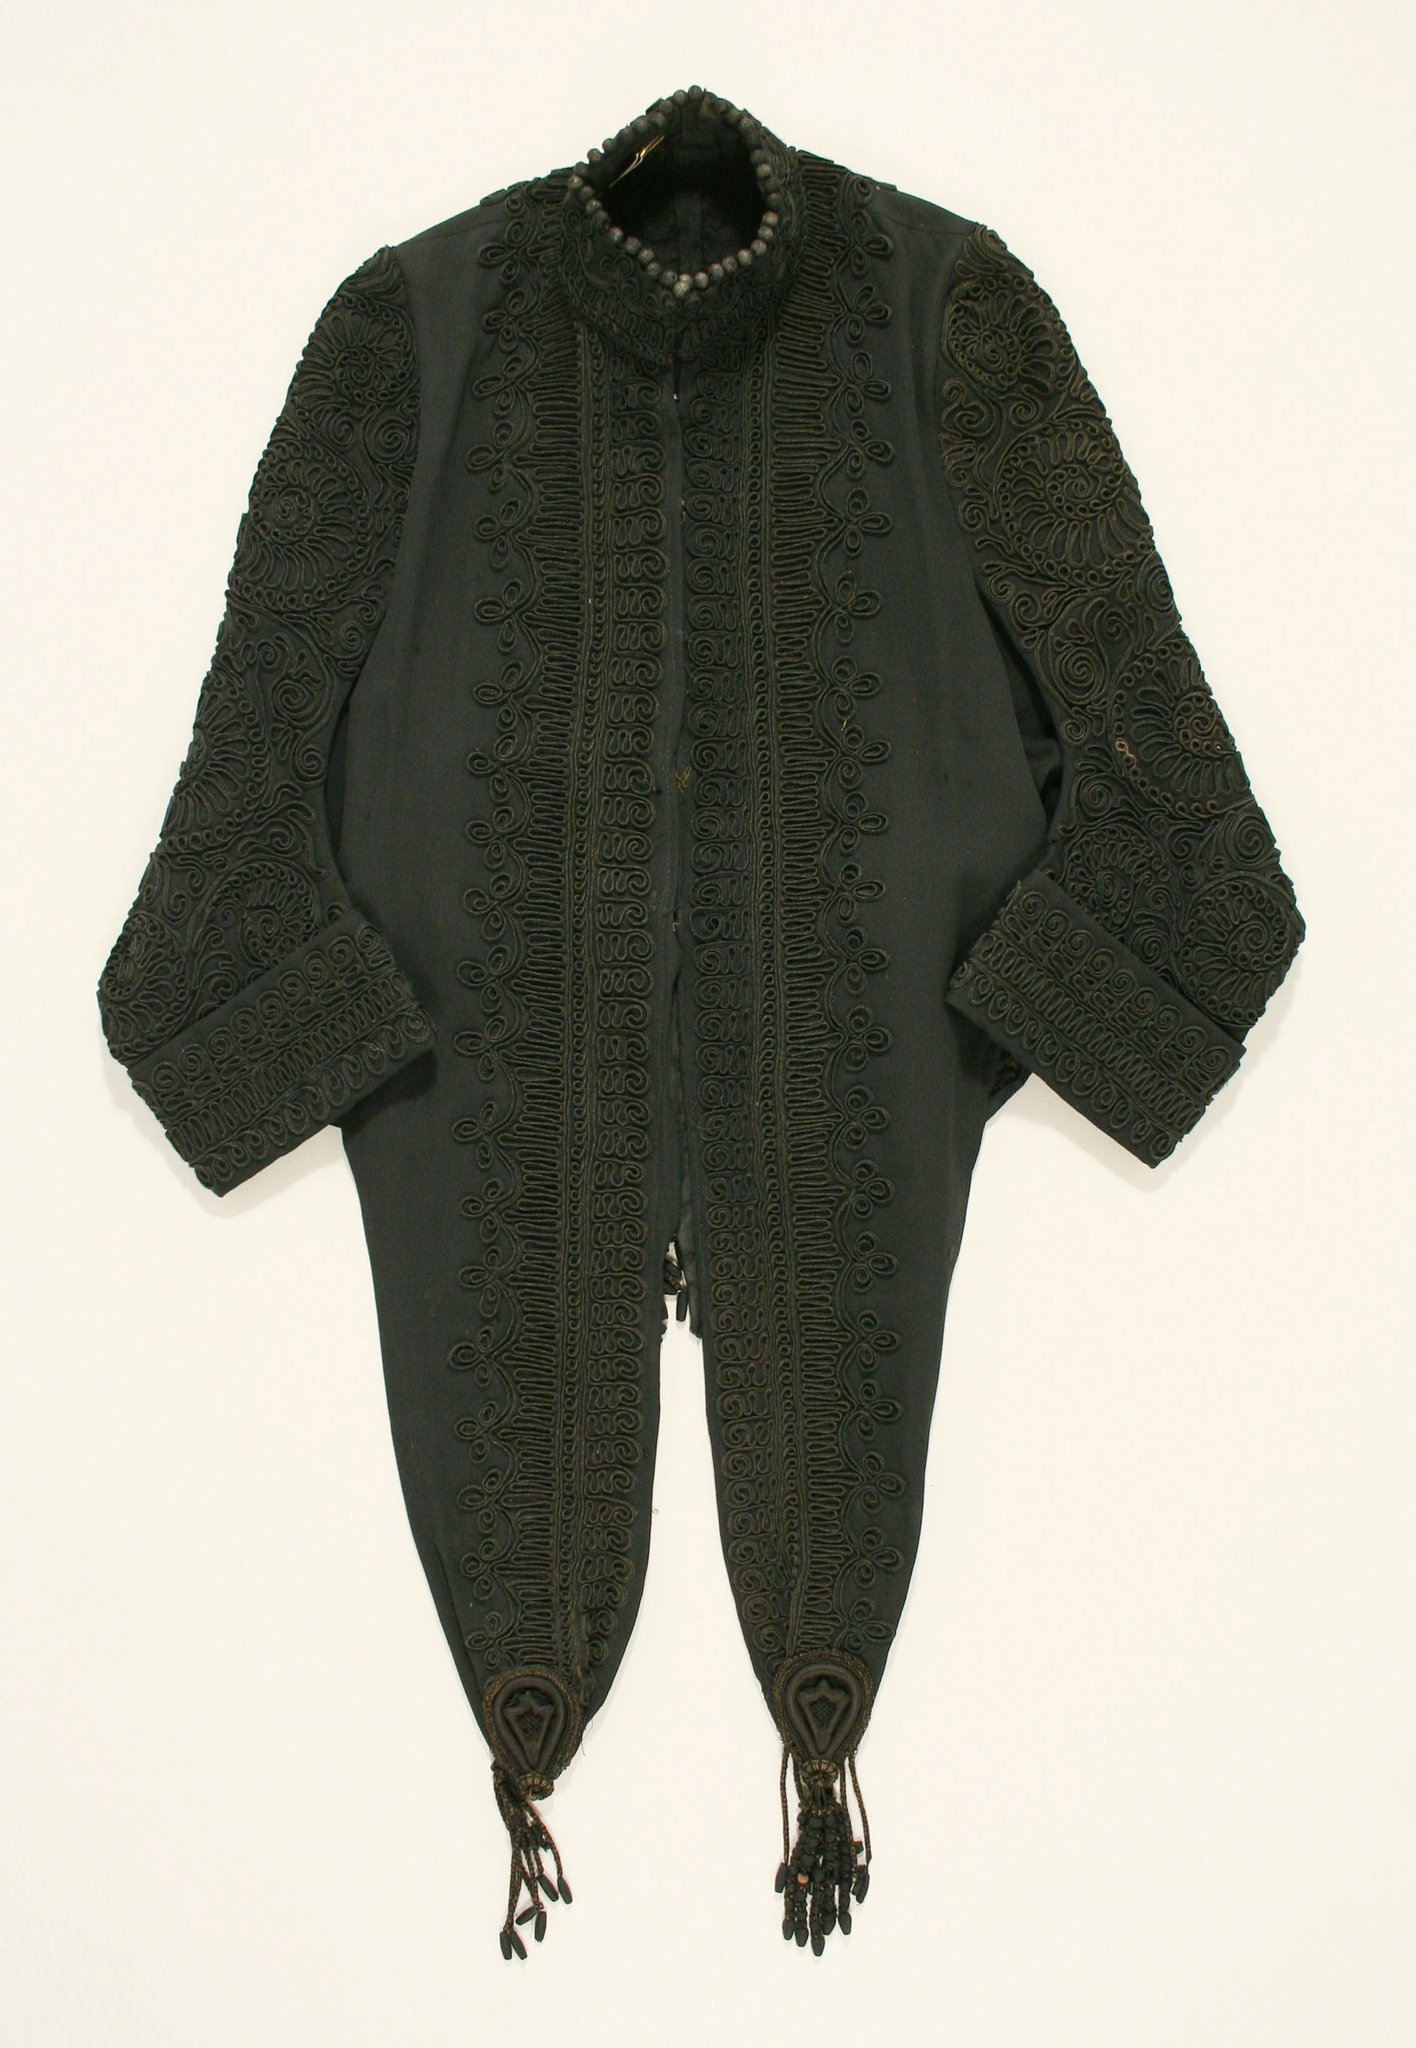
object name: jacket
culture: american or european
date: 1890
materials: silk